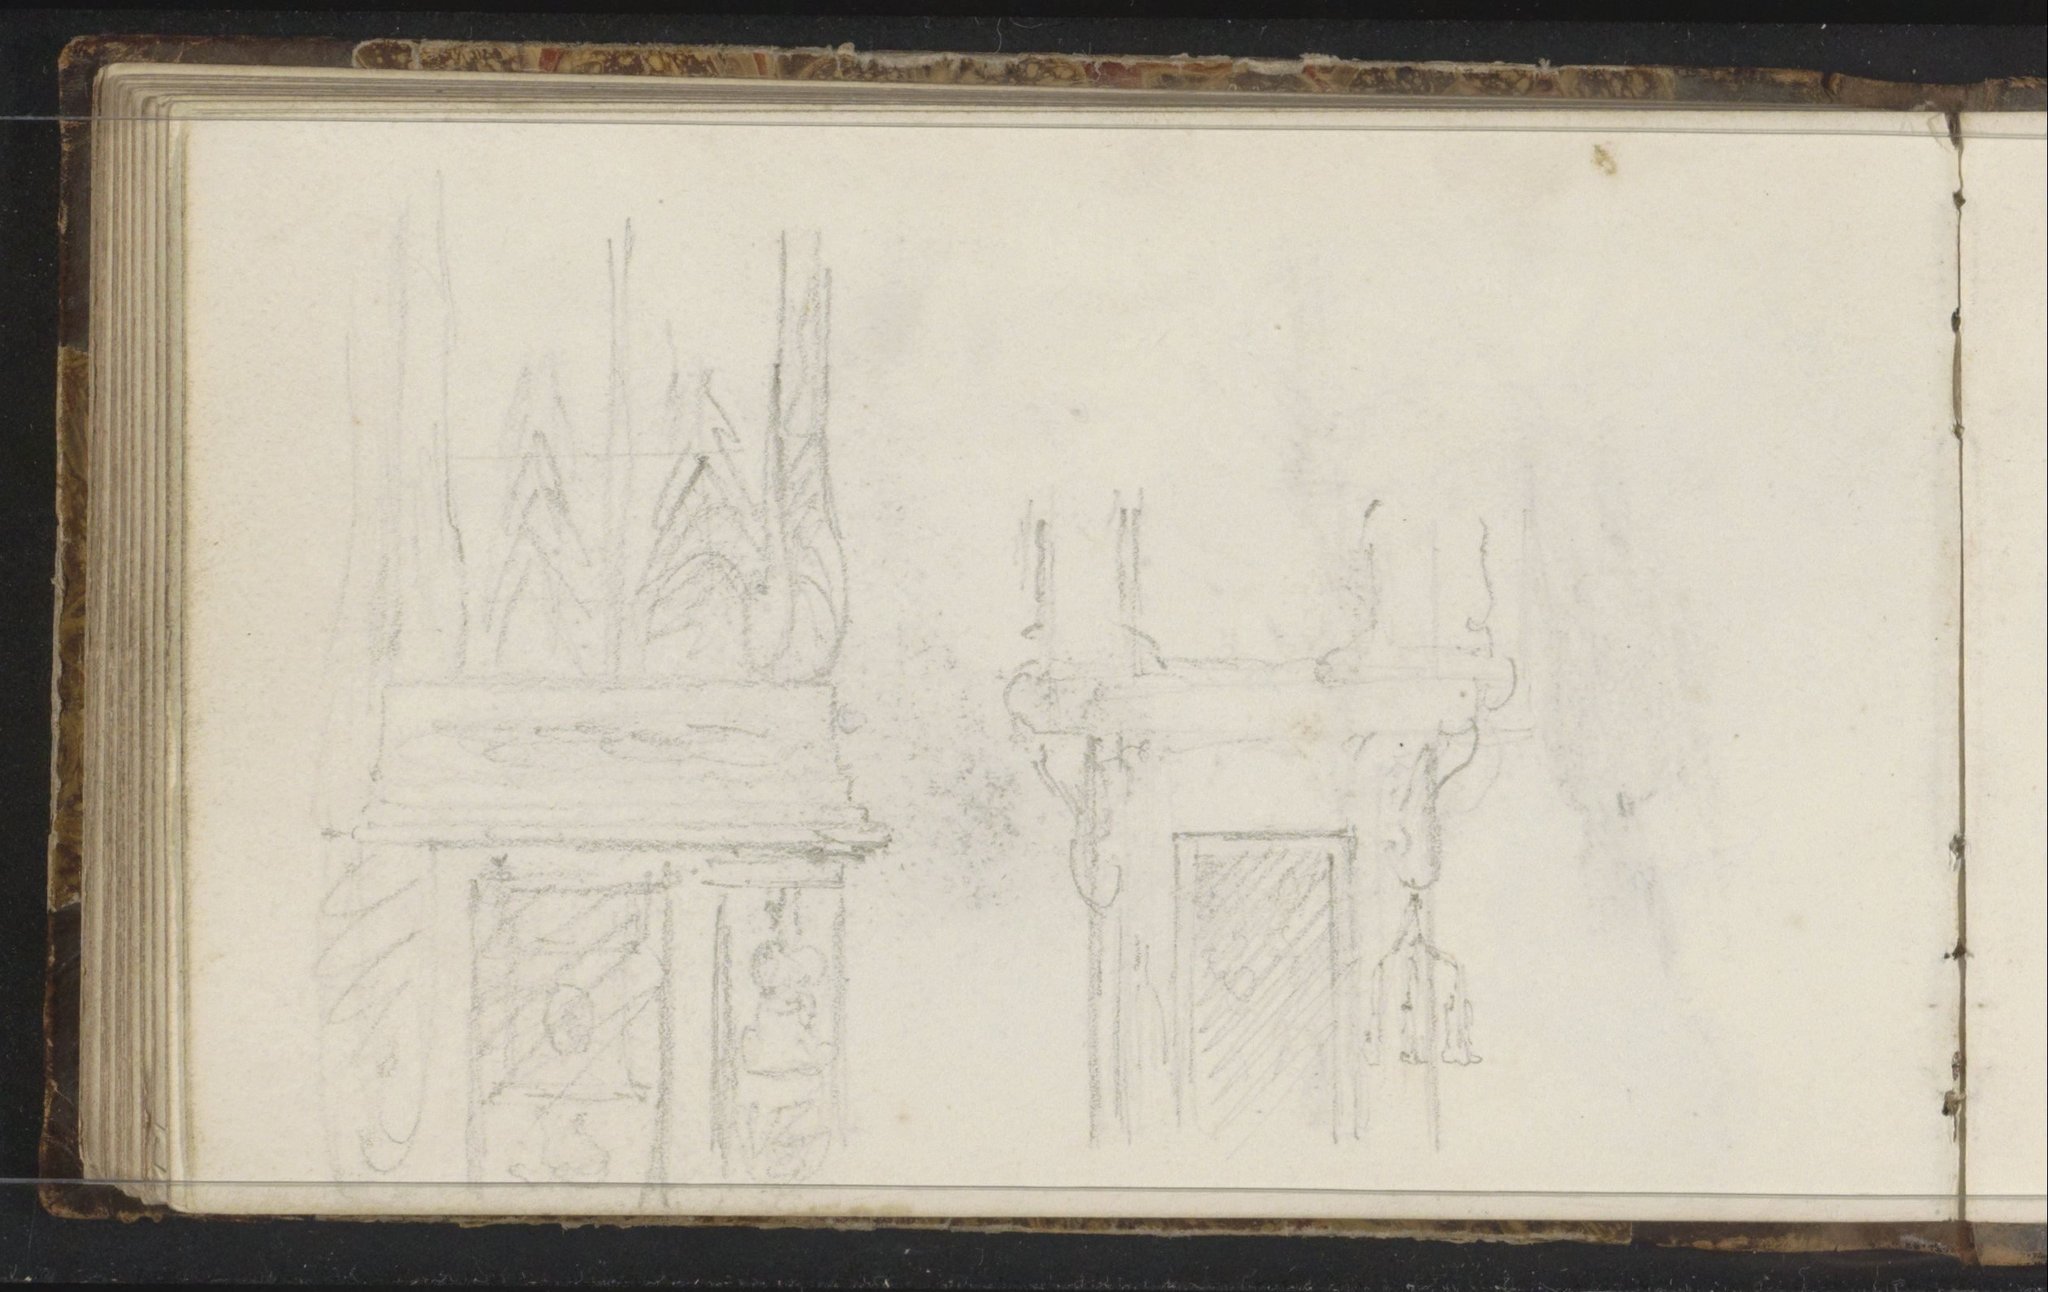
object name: sketchbook leaf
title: Schoorsteenmantel en een tafel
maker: willem hendrik schmidt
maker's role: draughtsman, painter, print maker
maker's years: 1809-1849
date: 1819-1849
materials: paper, pencil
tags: table, chimney-piece, mantelpiece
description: Blad 54 verso uit een schetsboek met 60 bladen.